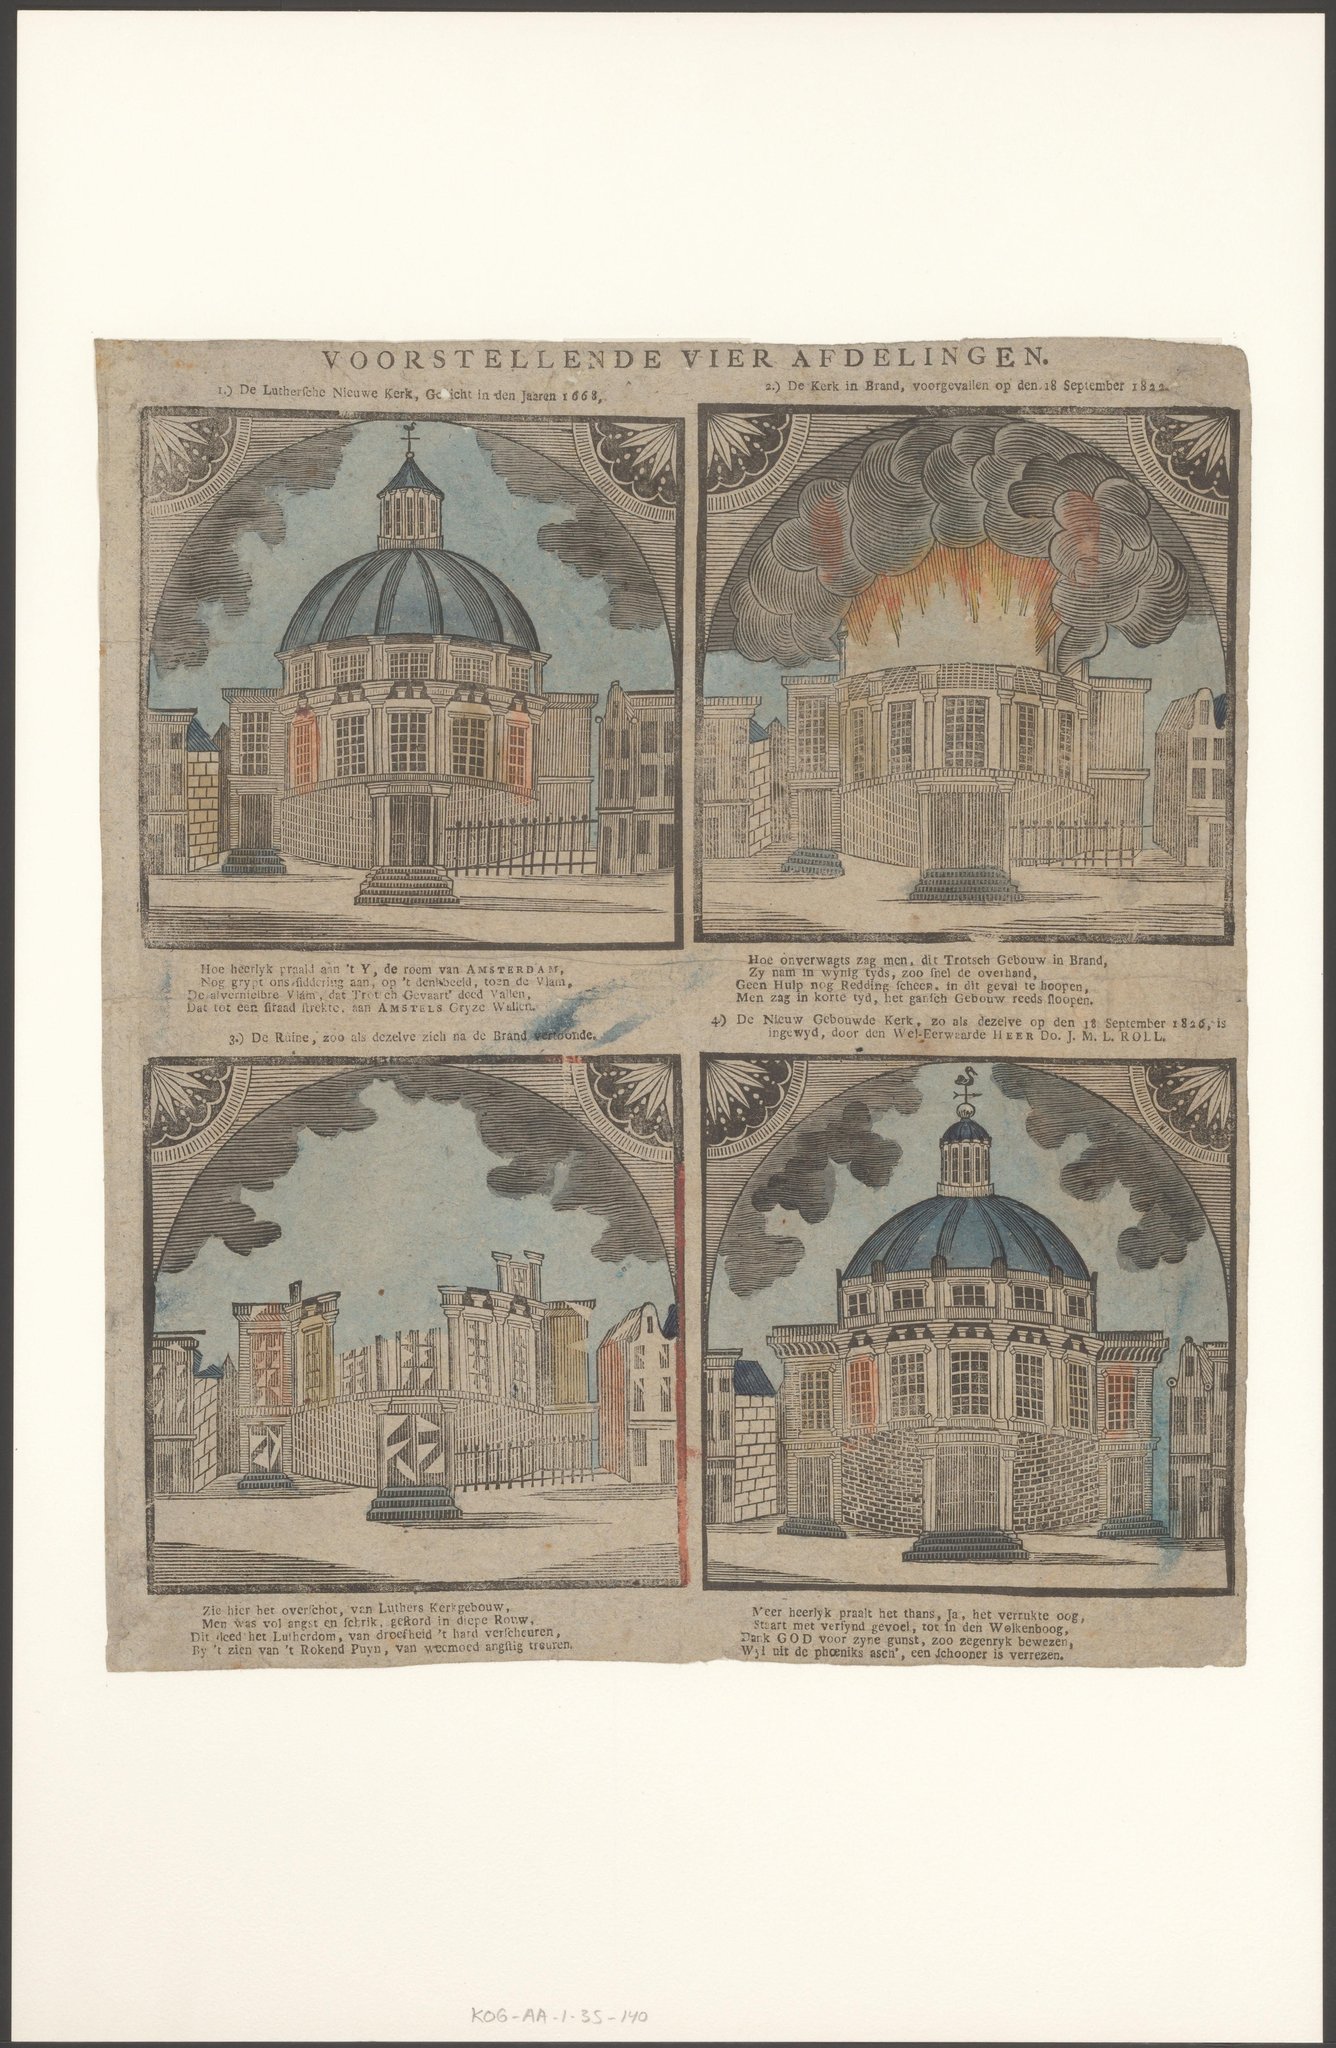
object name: popular print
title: Gezicht op de Nieuwe Lutherse Kerk, voor, tijdens en na de brand in 1822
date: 1831-1854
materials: paper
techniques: hand coloring, letterpress printing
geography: netherlands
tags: protestant churches and denominations (lutherans), parts of church exterior and annexes: dome, burning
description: Blad met vier voorstellingen van verschillende toestanden van de Ronde of Nieuwe Lutherse Kerk te Amsterdam, waaronder de kerk in brand op 18 september 1822, als een ruïne en opnieuw opgebouwd. Hier afgesneden maar oorspronkelijk rechtsboven genummerd: No. 51. Onderwerpsrubriek binnen de Atlas Amsterdam: Ev. Lutherse Gemeente: Nieuwe of Ronde Kerk.